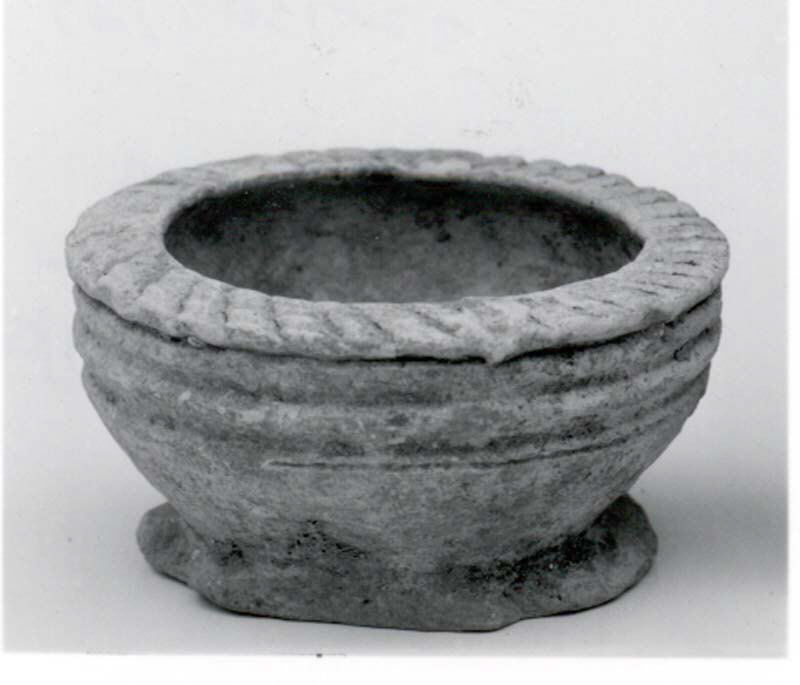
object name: pot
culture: sasanian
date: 201-700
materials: ceramic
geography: mesopotamia